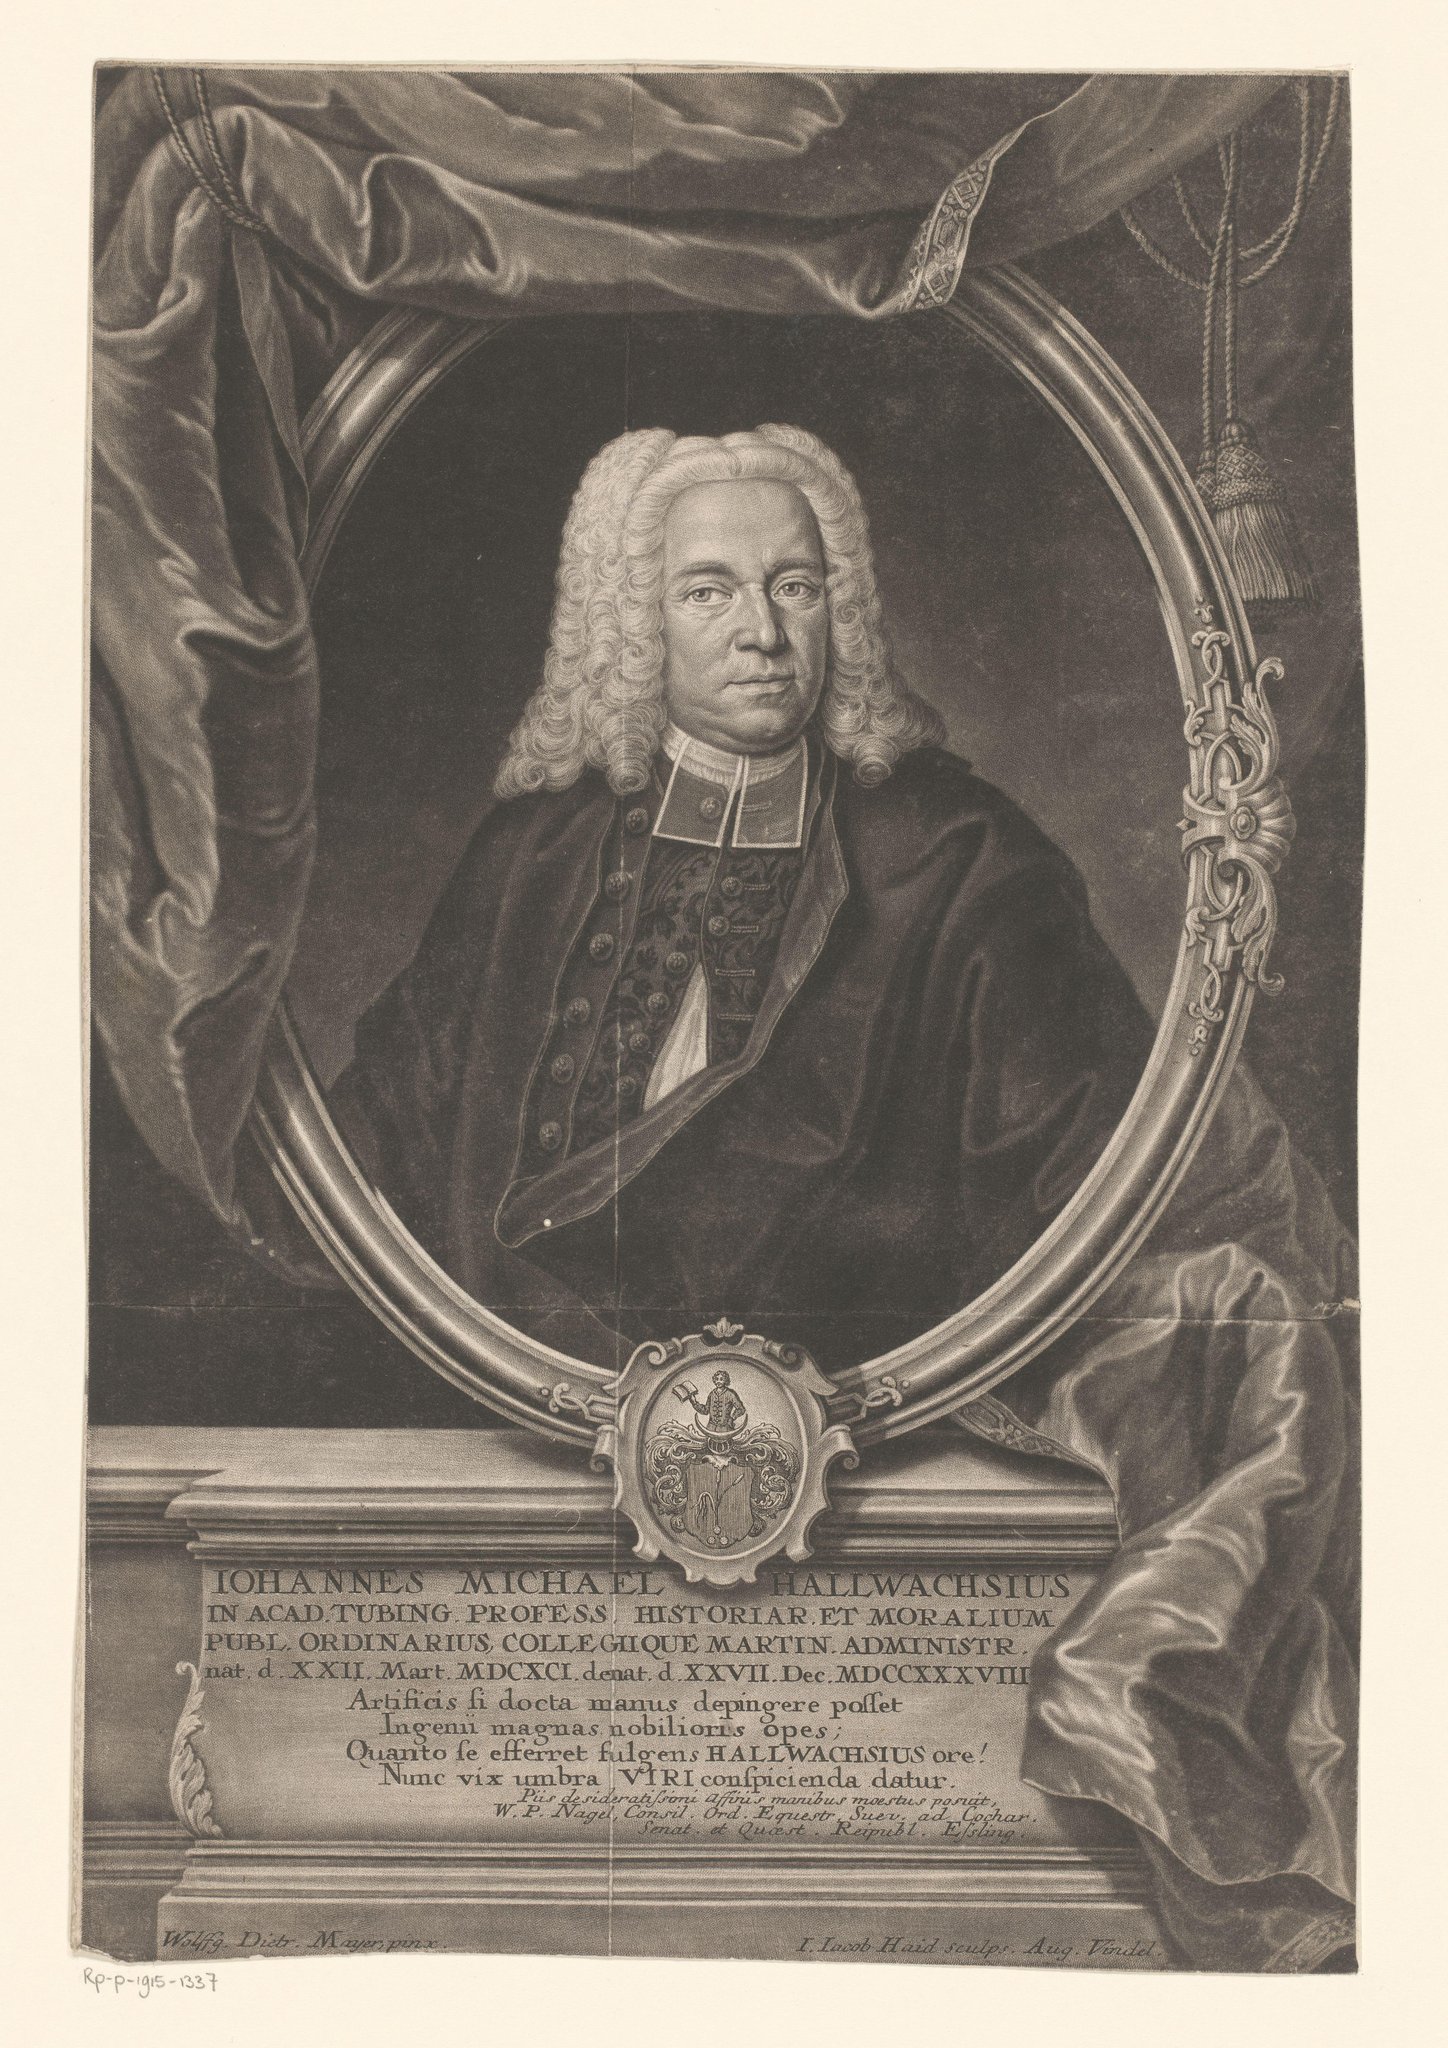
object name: print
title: Portret van Johann Michael Hallwachs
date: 1738-1767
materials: paper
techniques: etching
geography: augsburg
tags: historical persons, armorial bearing, heraldry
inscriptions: collector's mark: Lugt 2228